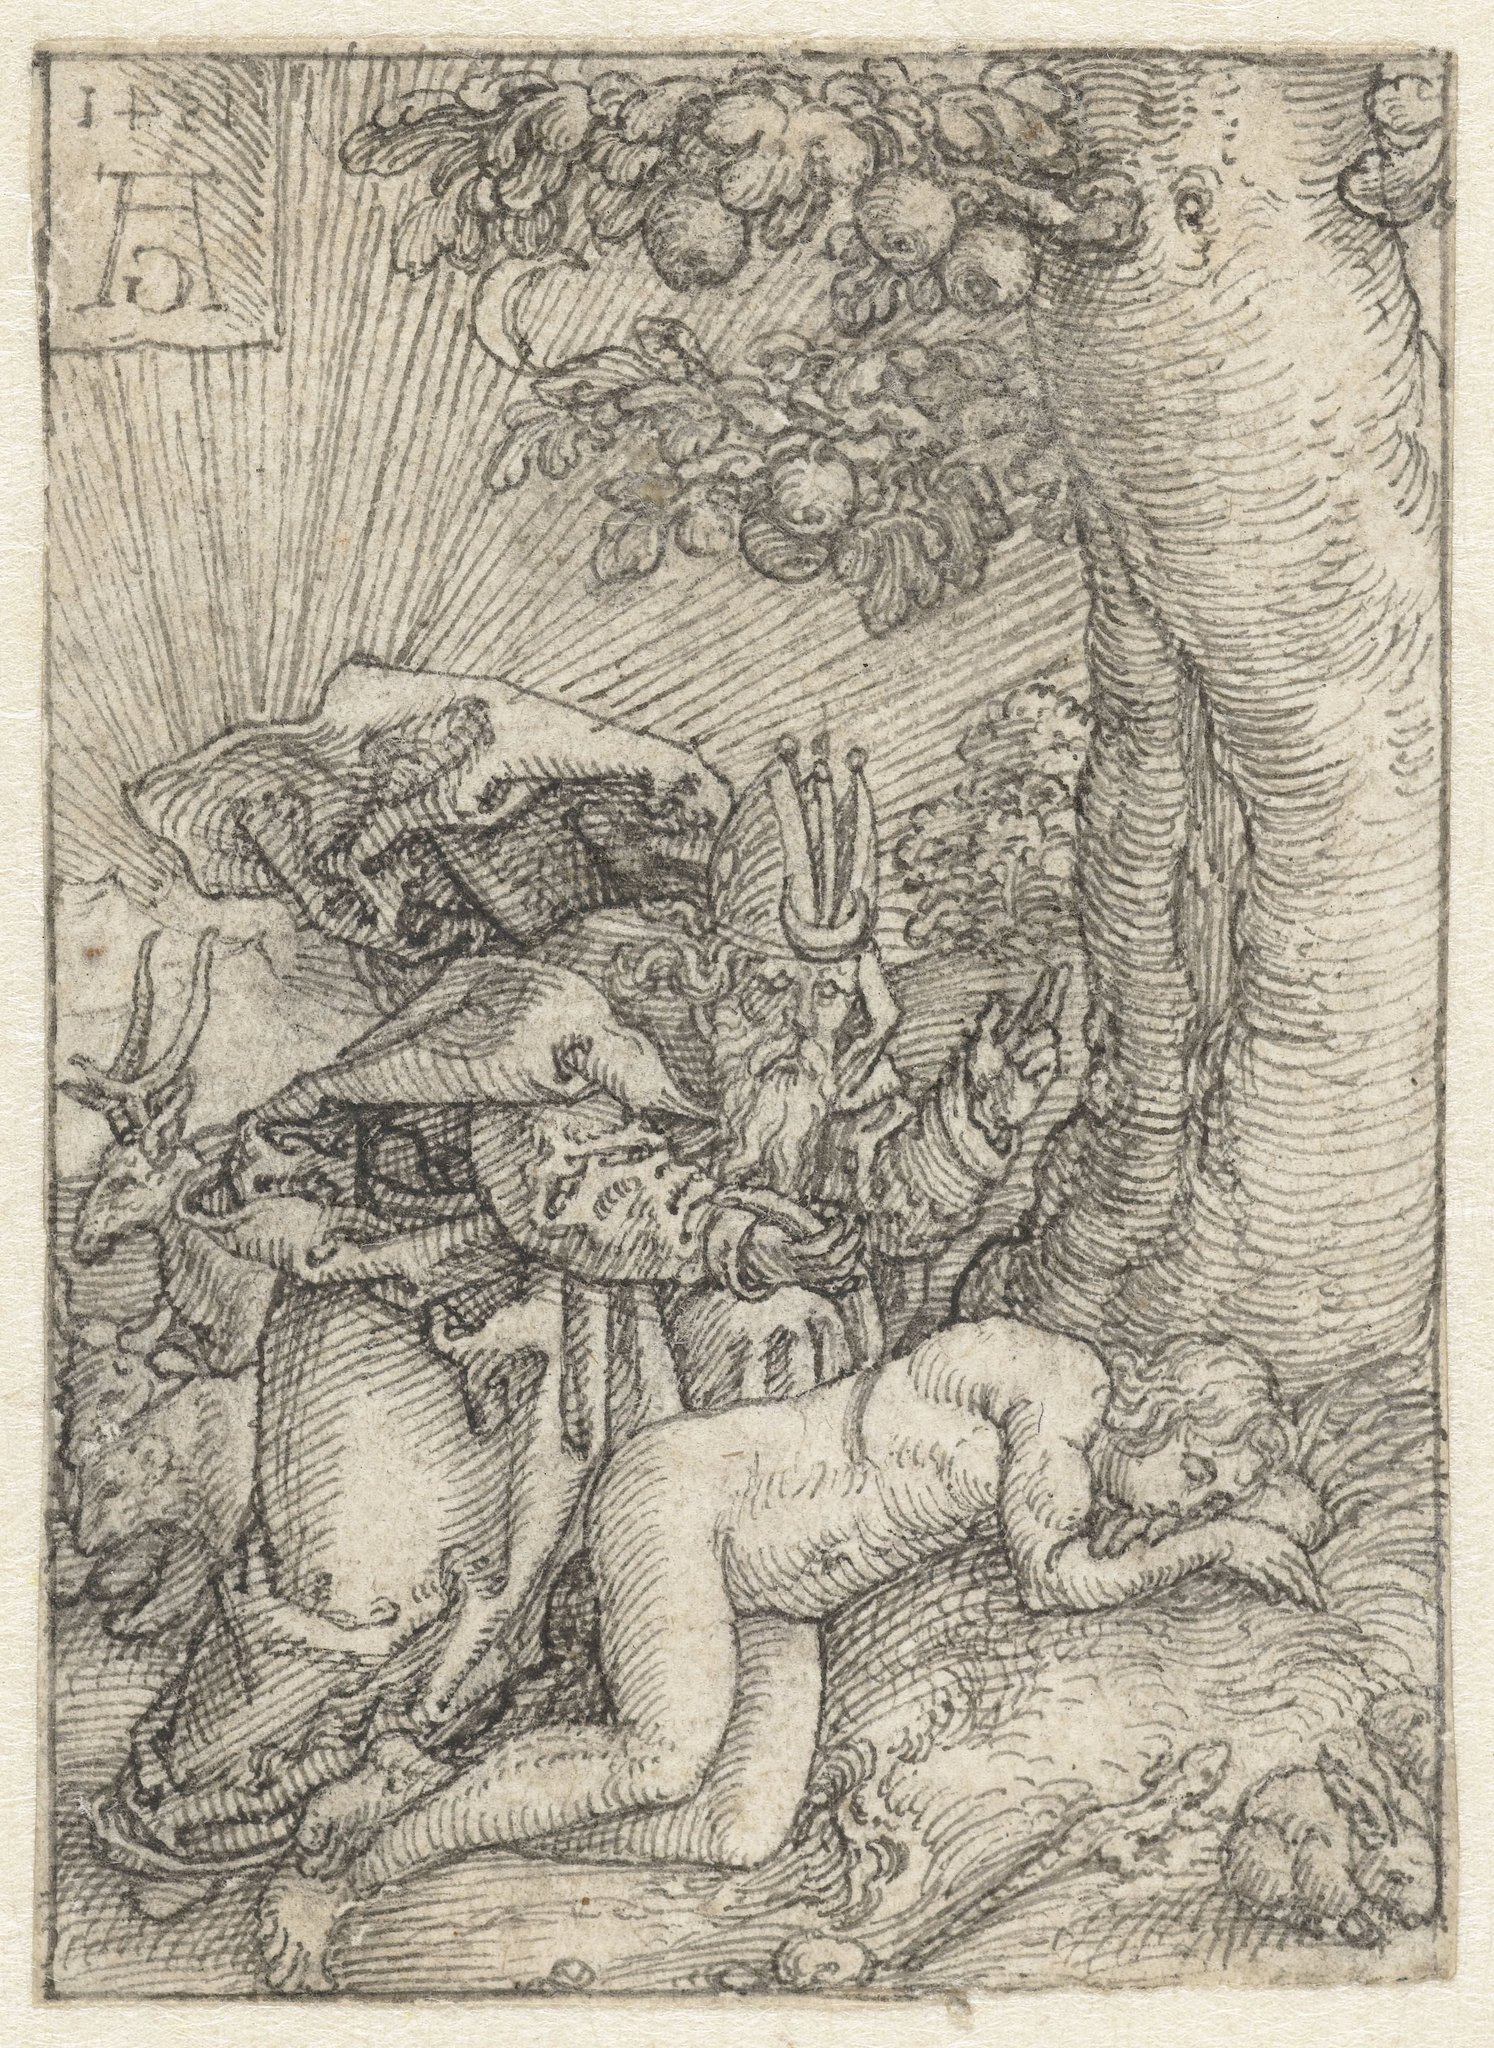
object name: design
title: Ontwerptekeningen voor de serie gravures "De Macht van de Dood"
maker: heinrich aldegrever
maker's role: draughtsman, print maker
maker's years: 1502-1561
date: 1541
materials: ink, paper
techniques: pen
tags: eve emerges from adam's body